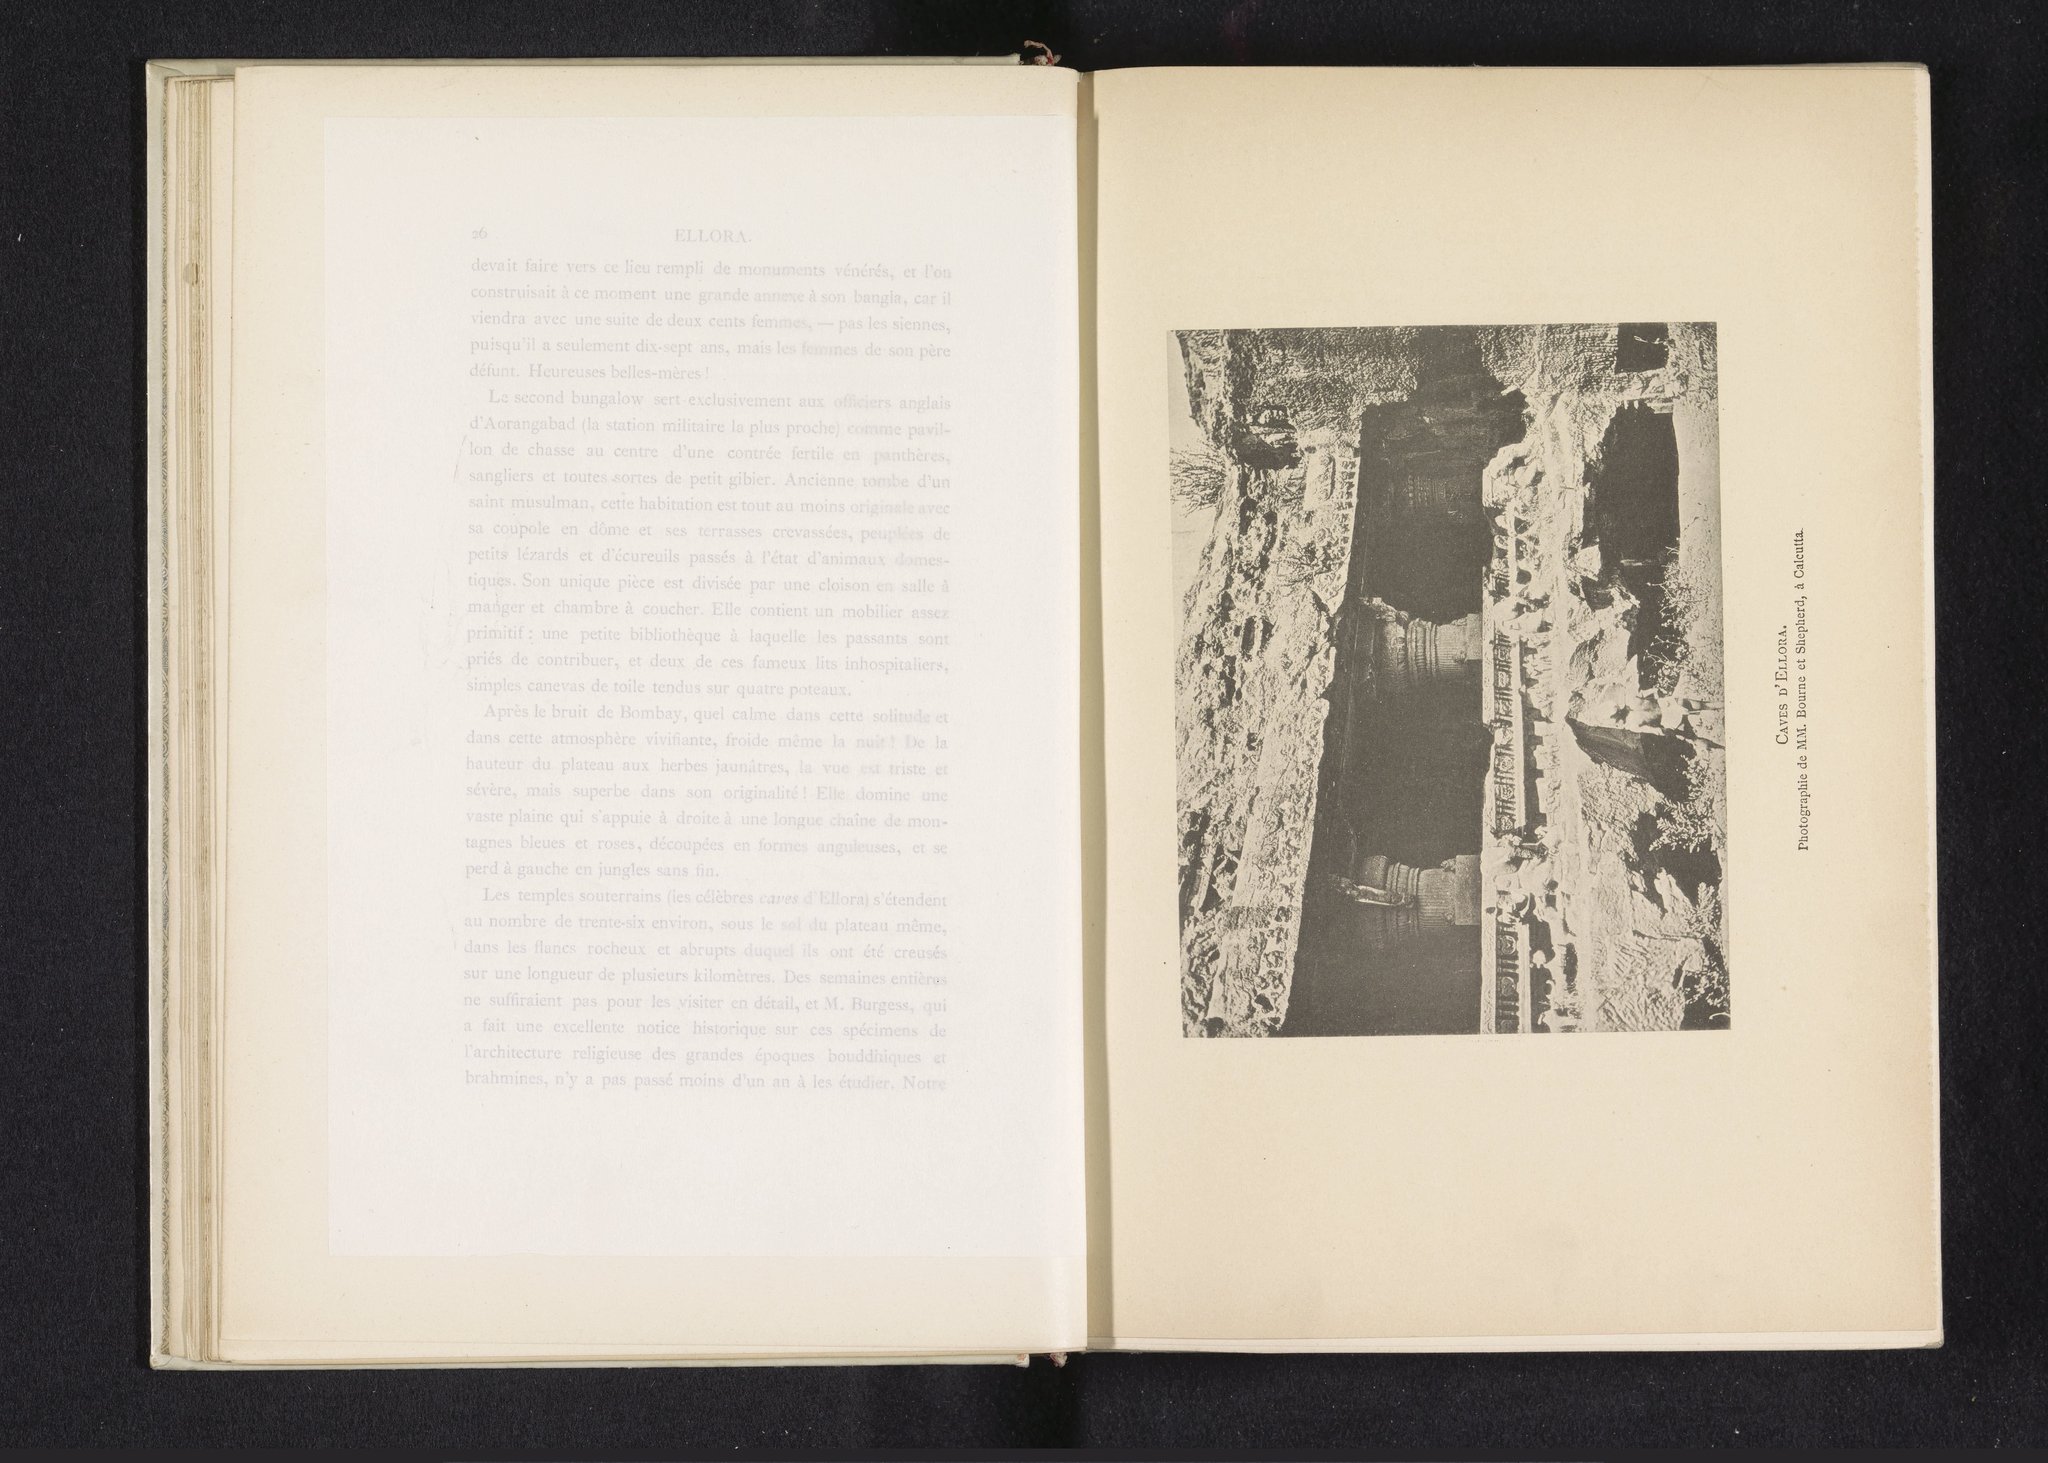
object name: photomechanical print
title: Exterieur van een geornamenteerde grottempel te Ellora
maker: Anonymous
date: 1875-1884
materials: paper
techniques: photograph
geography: ellora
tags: cave, grotto, temple, shrine ~ non-christian religions, sculpture (+ relief ~ sculpture)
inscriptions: inscription: ‘Photographie de MM. Bourne et Shepherd, à Calcutta.’